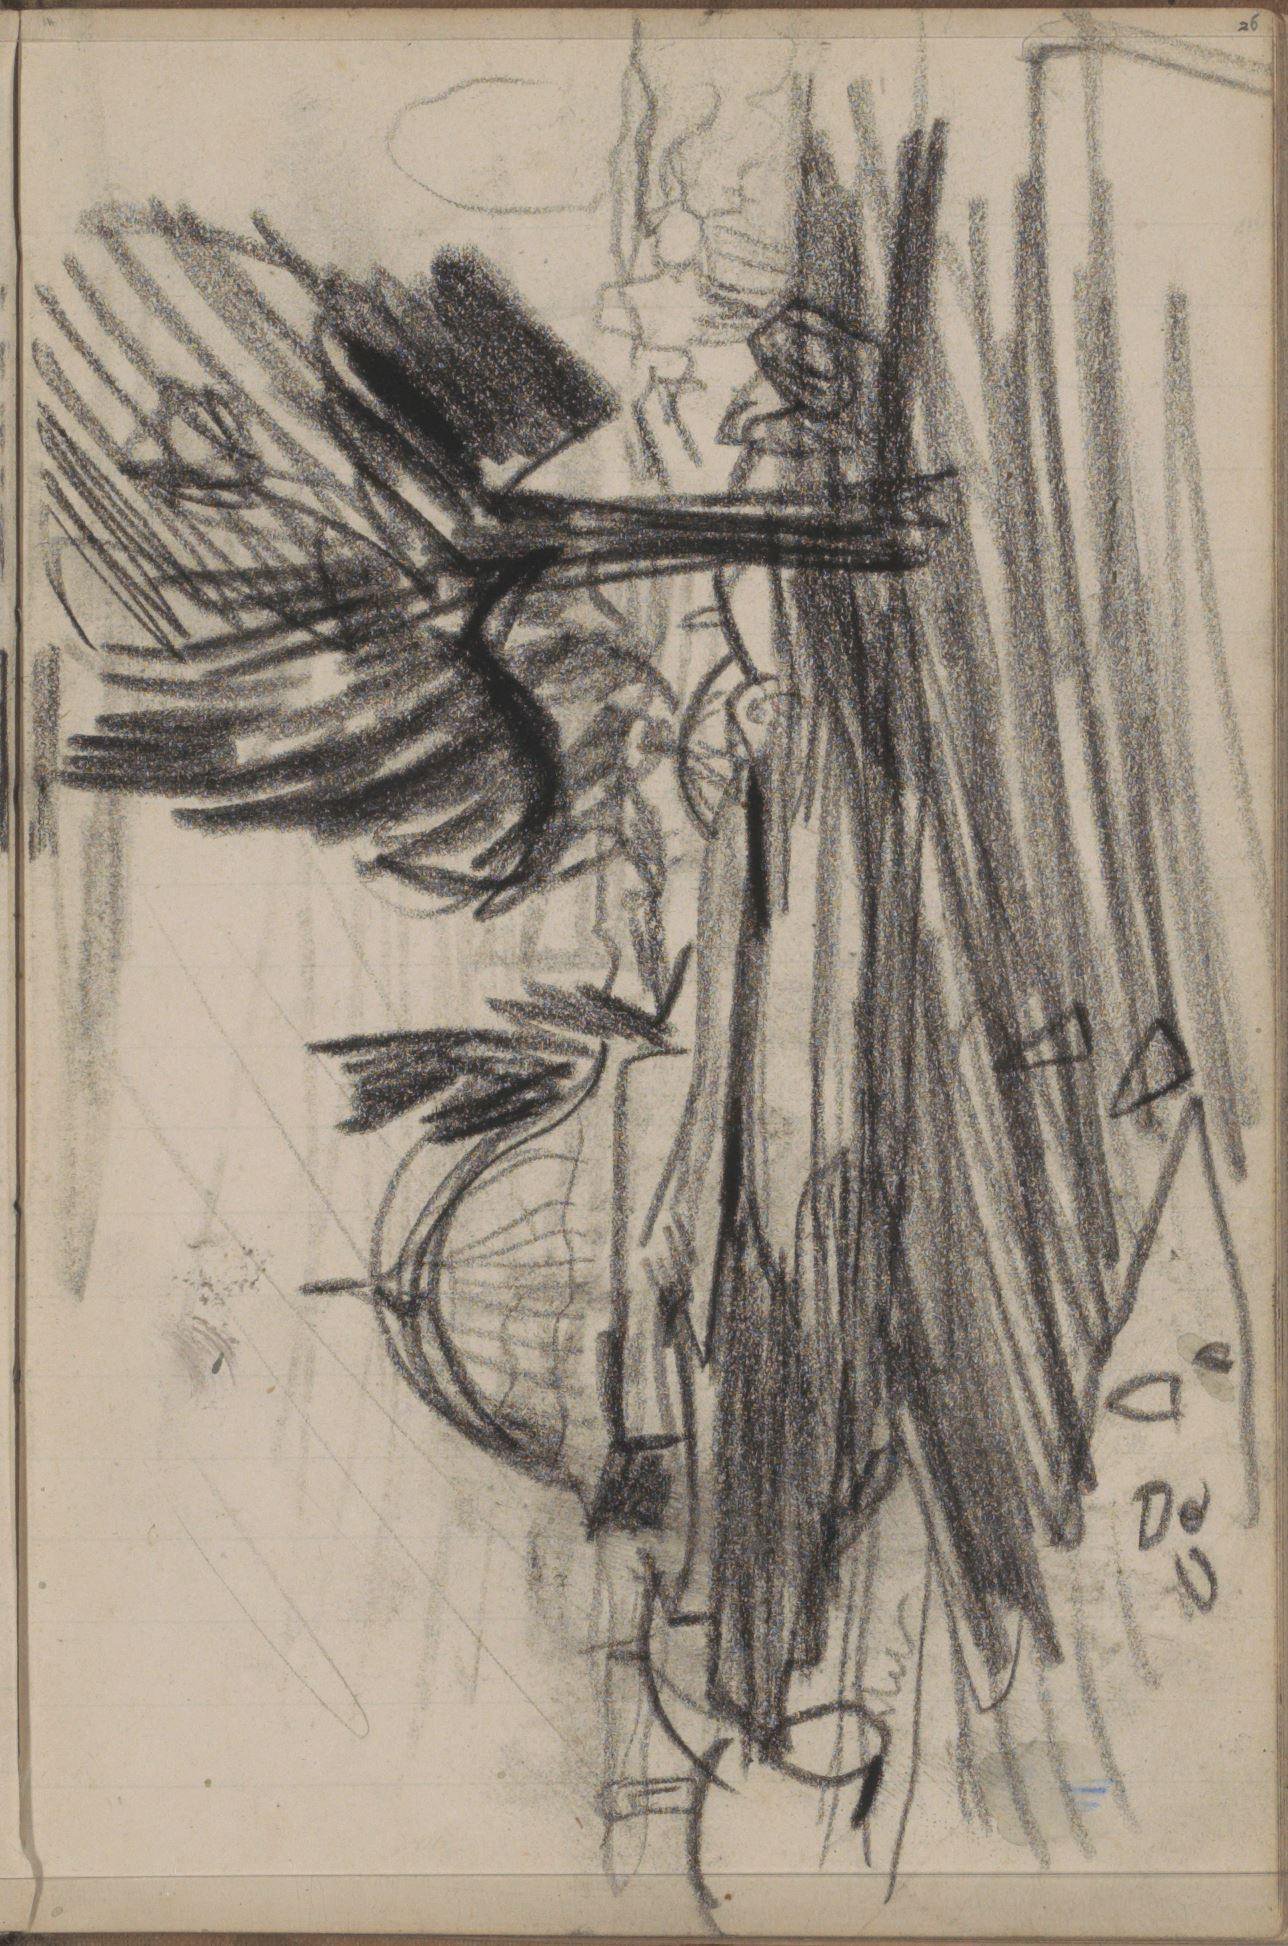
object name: sketchbook leaf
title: Landschap met een boom en koepels van een moskee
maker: marius bauer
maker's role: draughtsman, print maker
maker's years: 1867-1932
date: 1888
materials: chalk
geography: istanbul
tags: city-view, and landscape with man-made constructions, trees, temple, shrine ~ islam, mohammedanism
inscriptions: kleurnotitie, handgeschreven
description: Pagina 26 uit een schetsboek met 56 bladen.